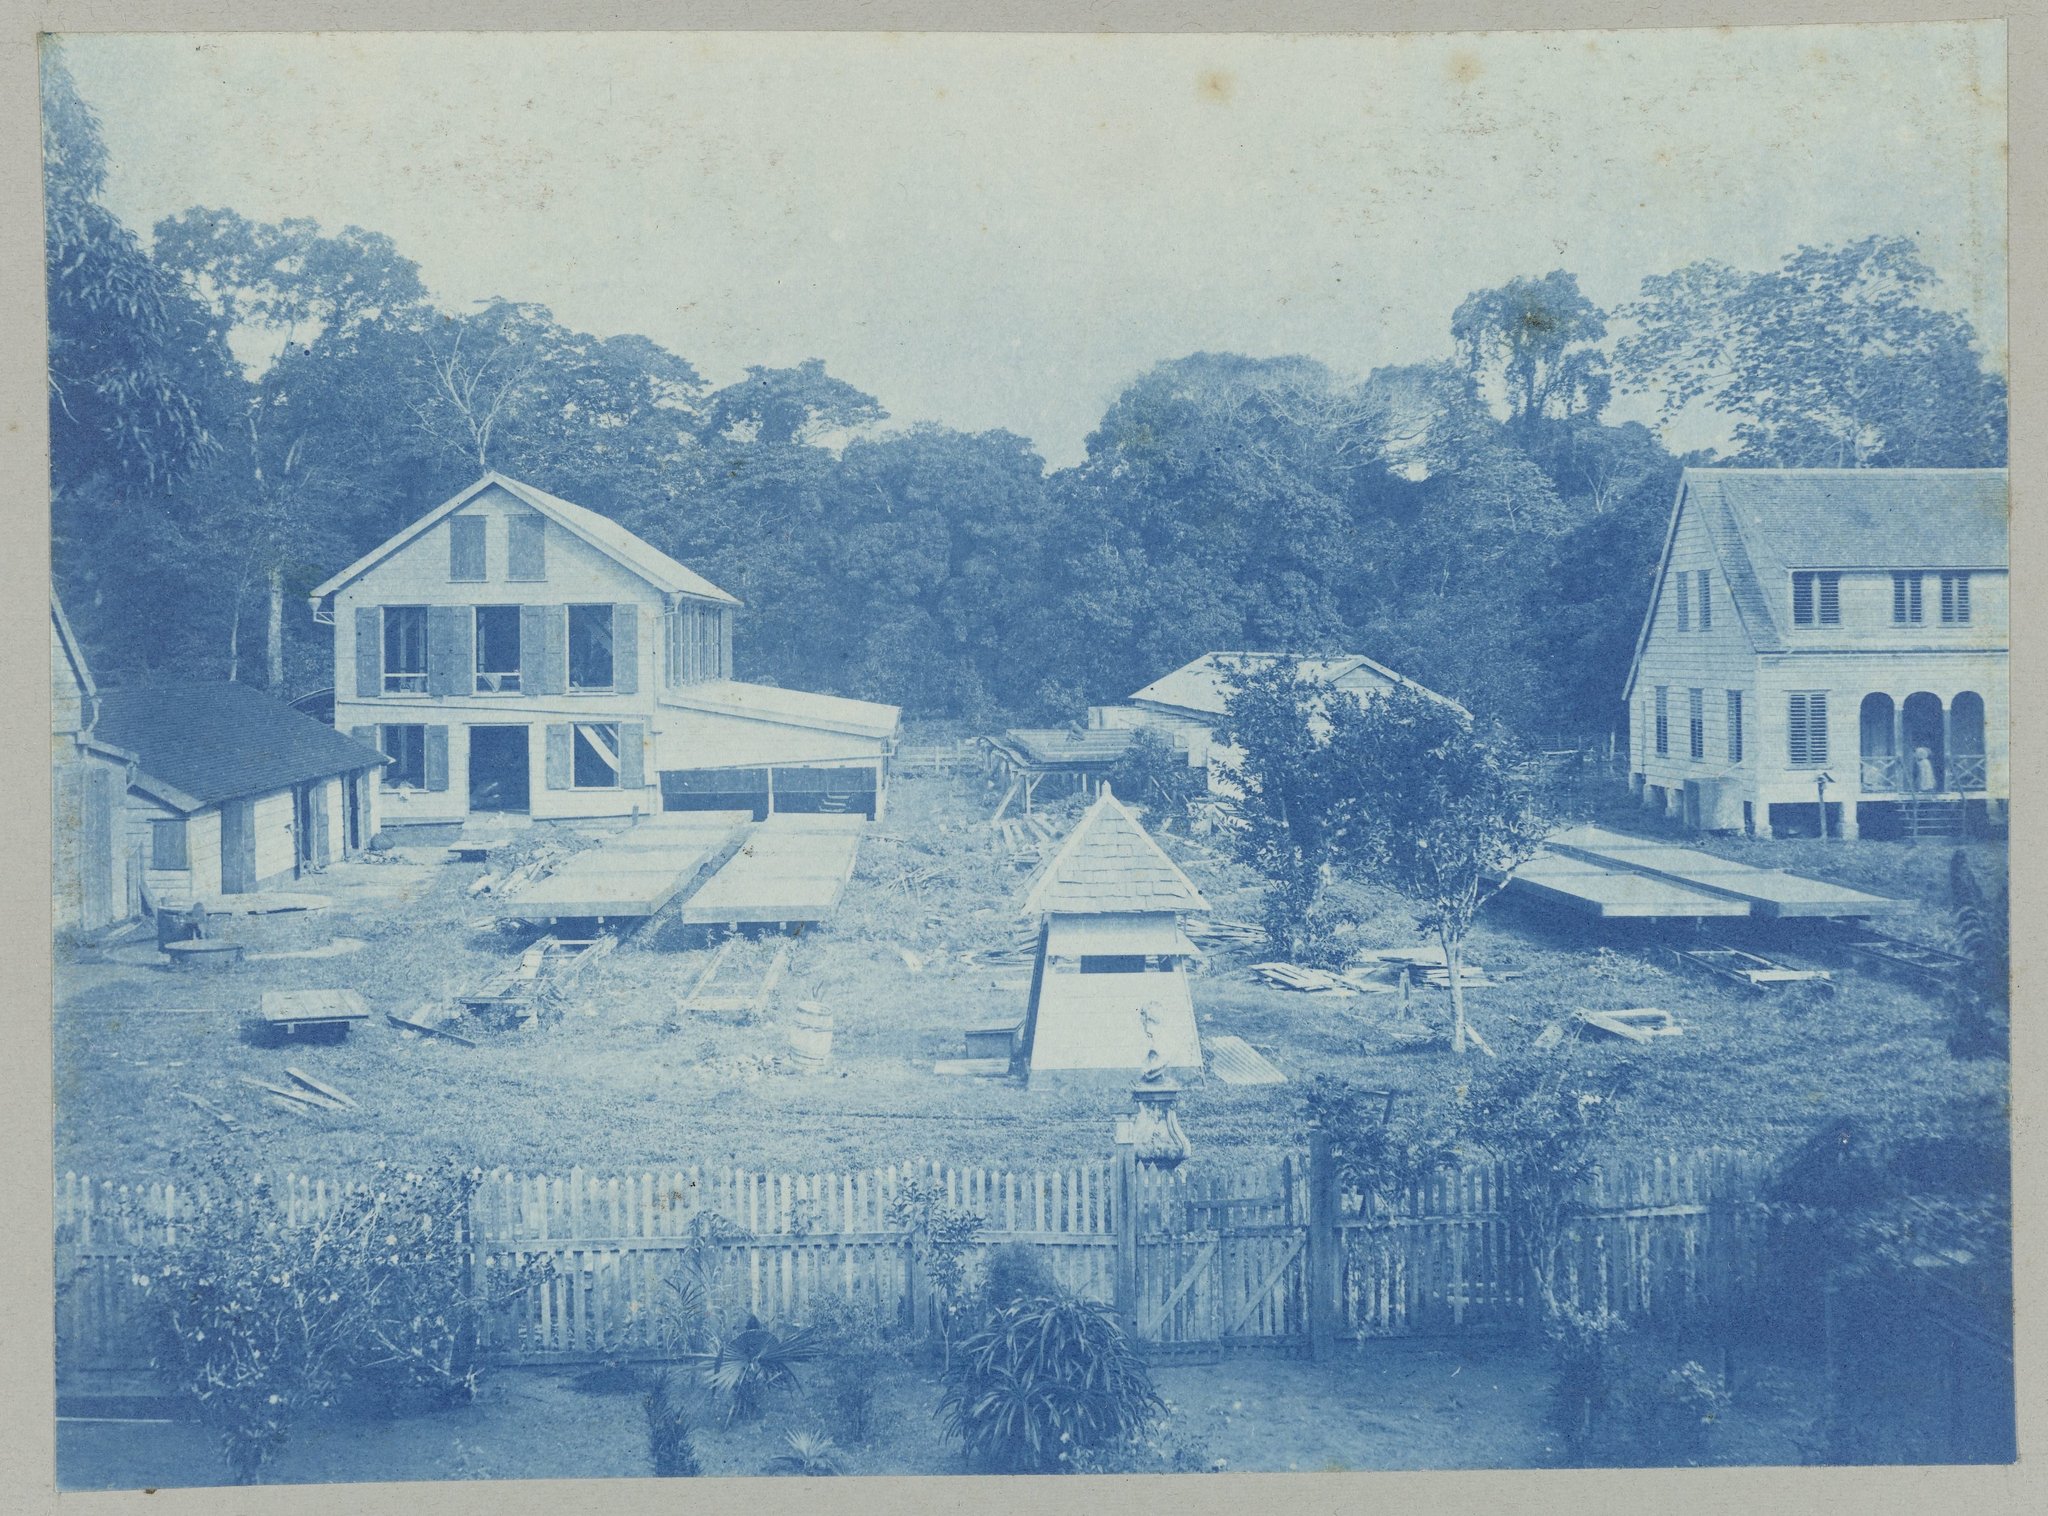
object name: photograph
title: Loodsen en hospitaal van "Ma retraite", gezien uit het plantagehuis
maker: hendrik doijer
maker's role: engineer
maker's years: 1863-1925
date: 1903-1910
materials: photographic support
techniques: cyanotype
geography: suriname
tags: suriname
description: Gezicht op enkele loodsen en het hospitaal van de plantage Ma Retraite. Op de voorgrond de tuin met planten en schutting van het plantagehuis, daarachter een theehuisje en verschillende langwerpige bakken, gezien vanuit het plantagehuis. Onderdeel van het fotoalbum Souvenir de Voyage (deel 1), over het leven van de familie Doijer in en rond de plantage Ma Retraite in Suriname in de jaren 1903-1910.